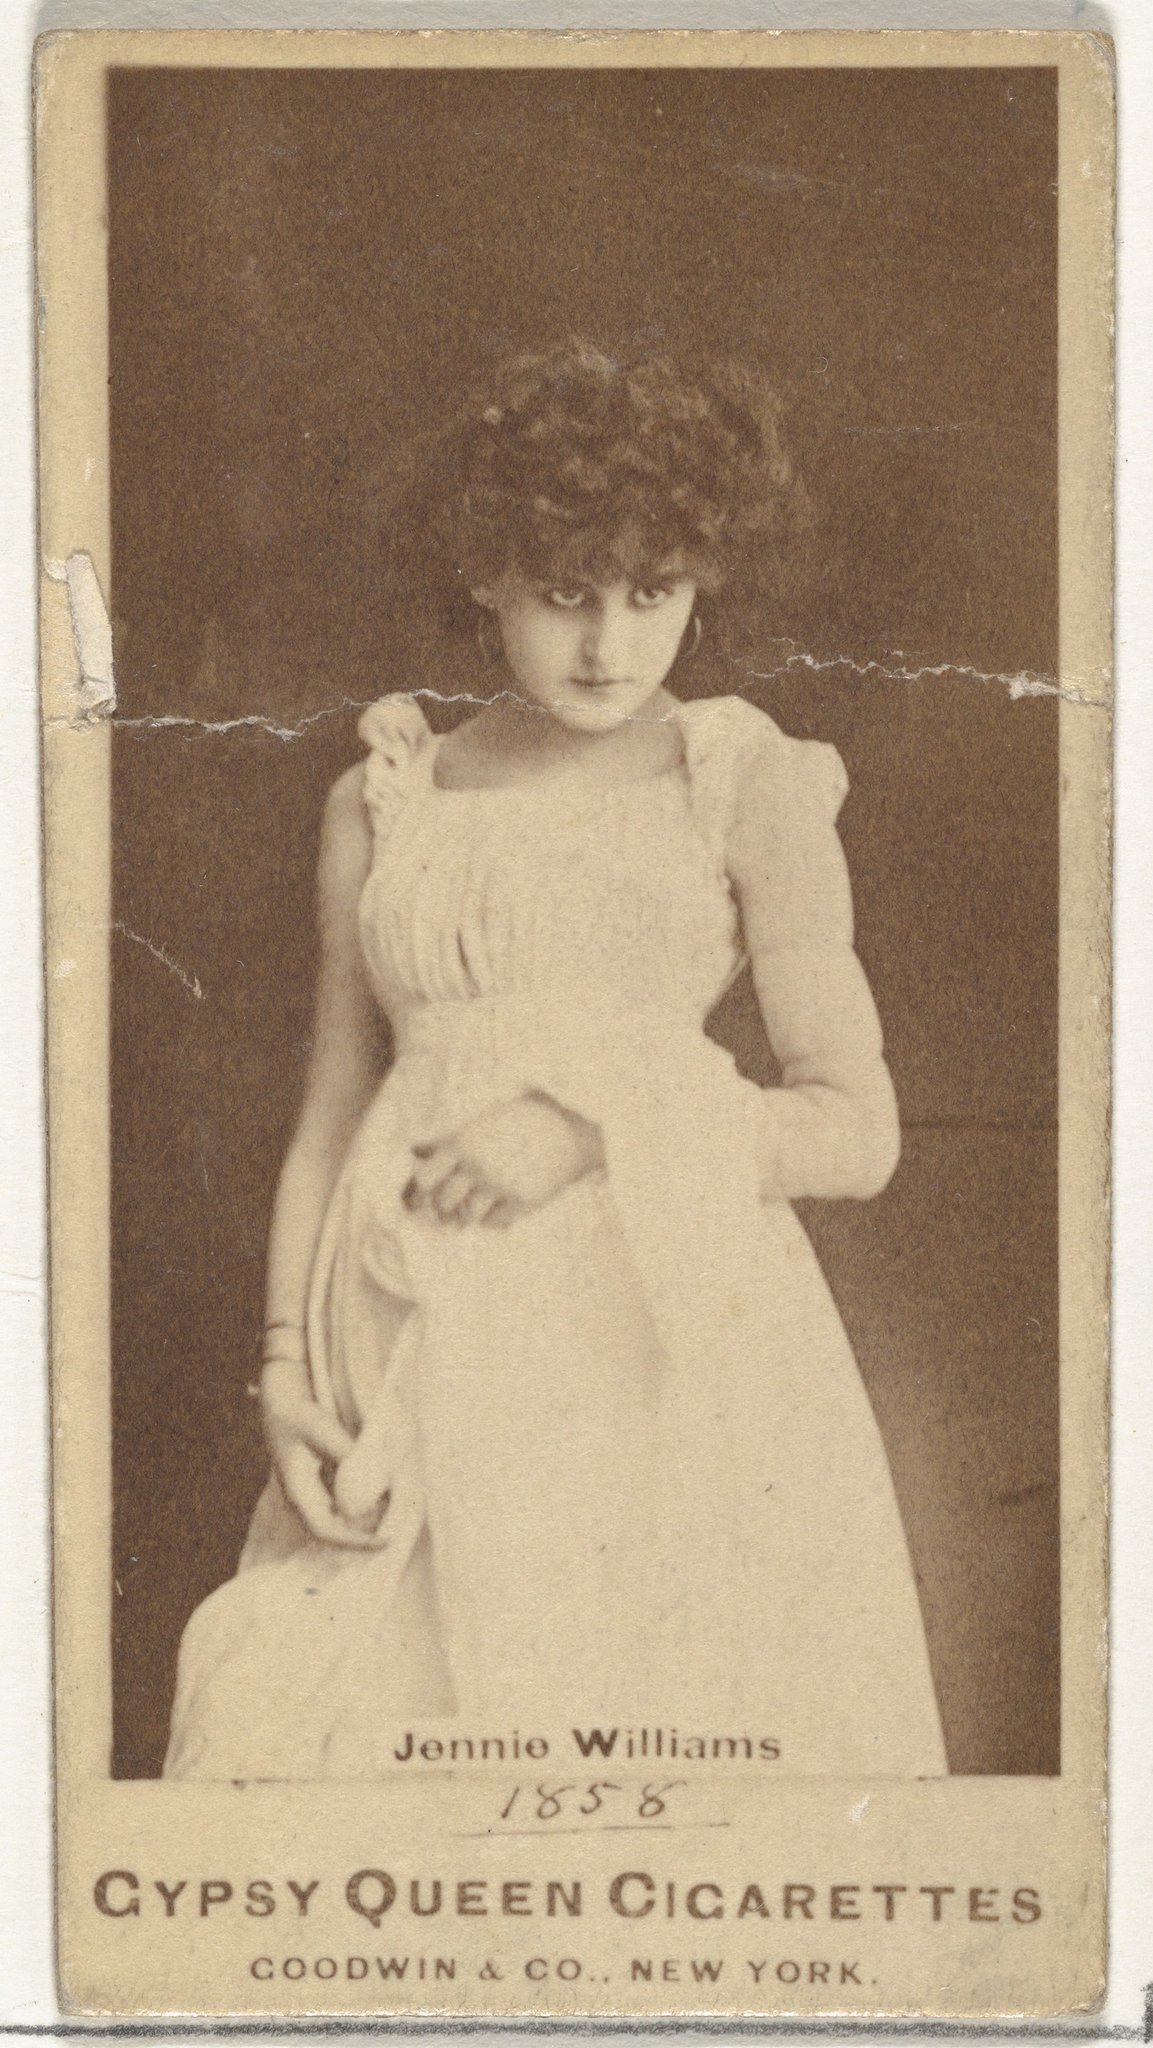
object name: photograph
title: Jennie Williams, from the Actors and Actresses series (N171) for Gypsy Queen Cigarettes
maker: goodwin & company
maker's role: publisher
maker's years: 1850-1950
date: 1886-1890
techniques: albumen silver print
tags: portraits,women,actresses